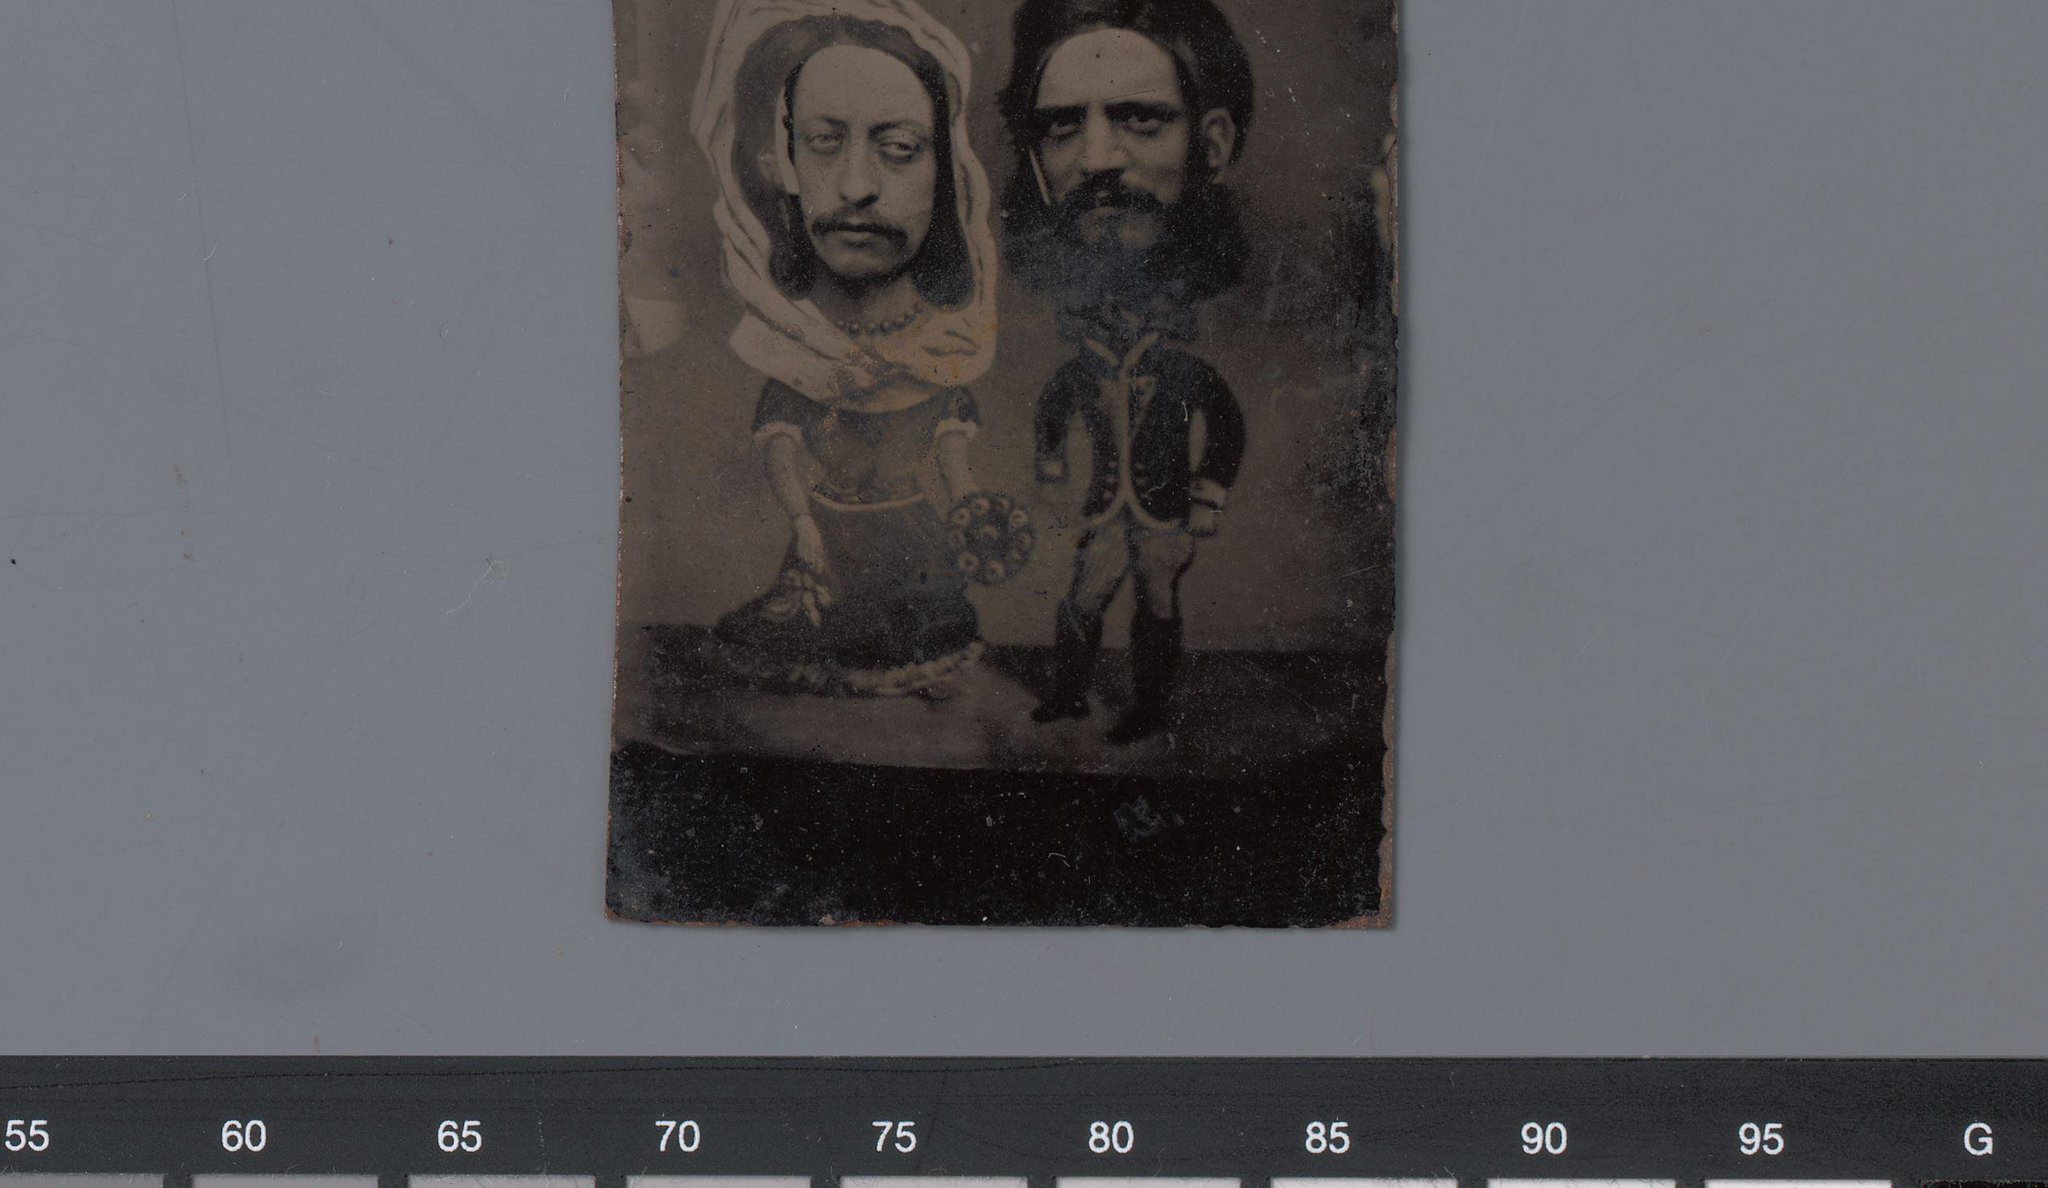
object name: photograph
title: Portret van twee onbekende mannen in geschilderd decor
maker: Anonymous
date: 1855-1940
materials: iron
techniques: ferrotyping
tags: set, scenery ~ stage, adult man (+ two persons), historical persons